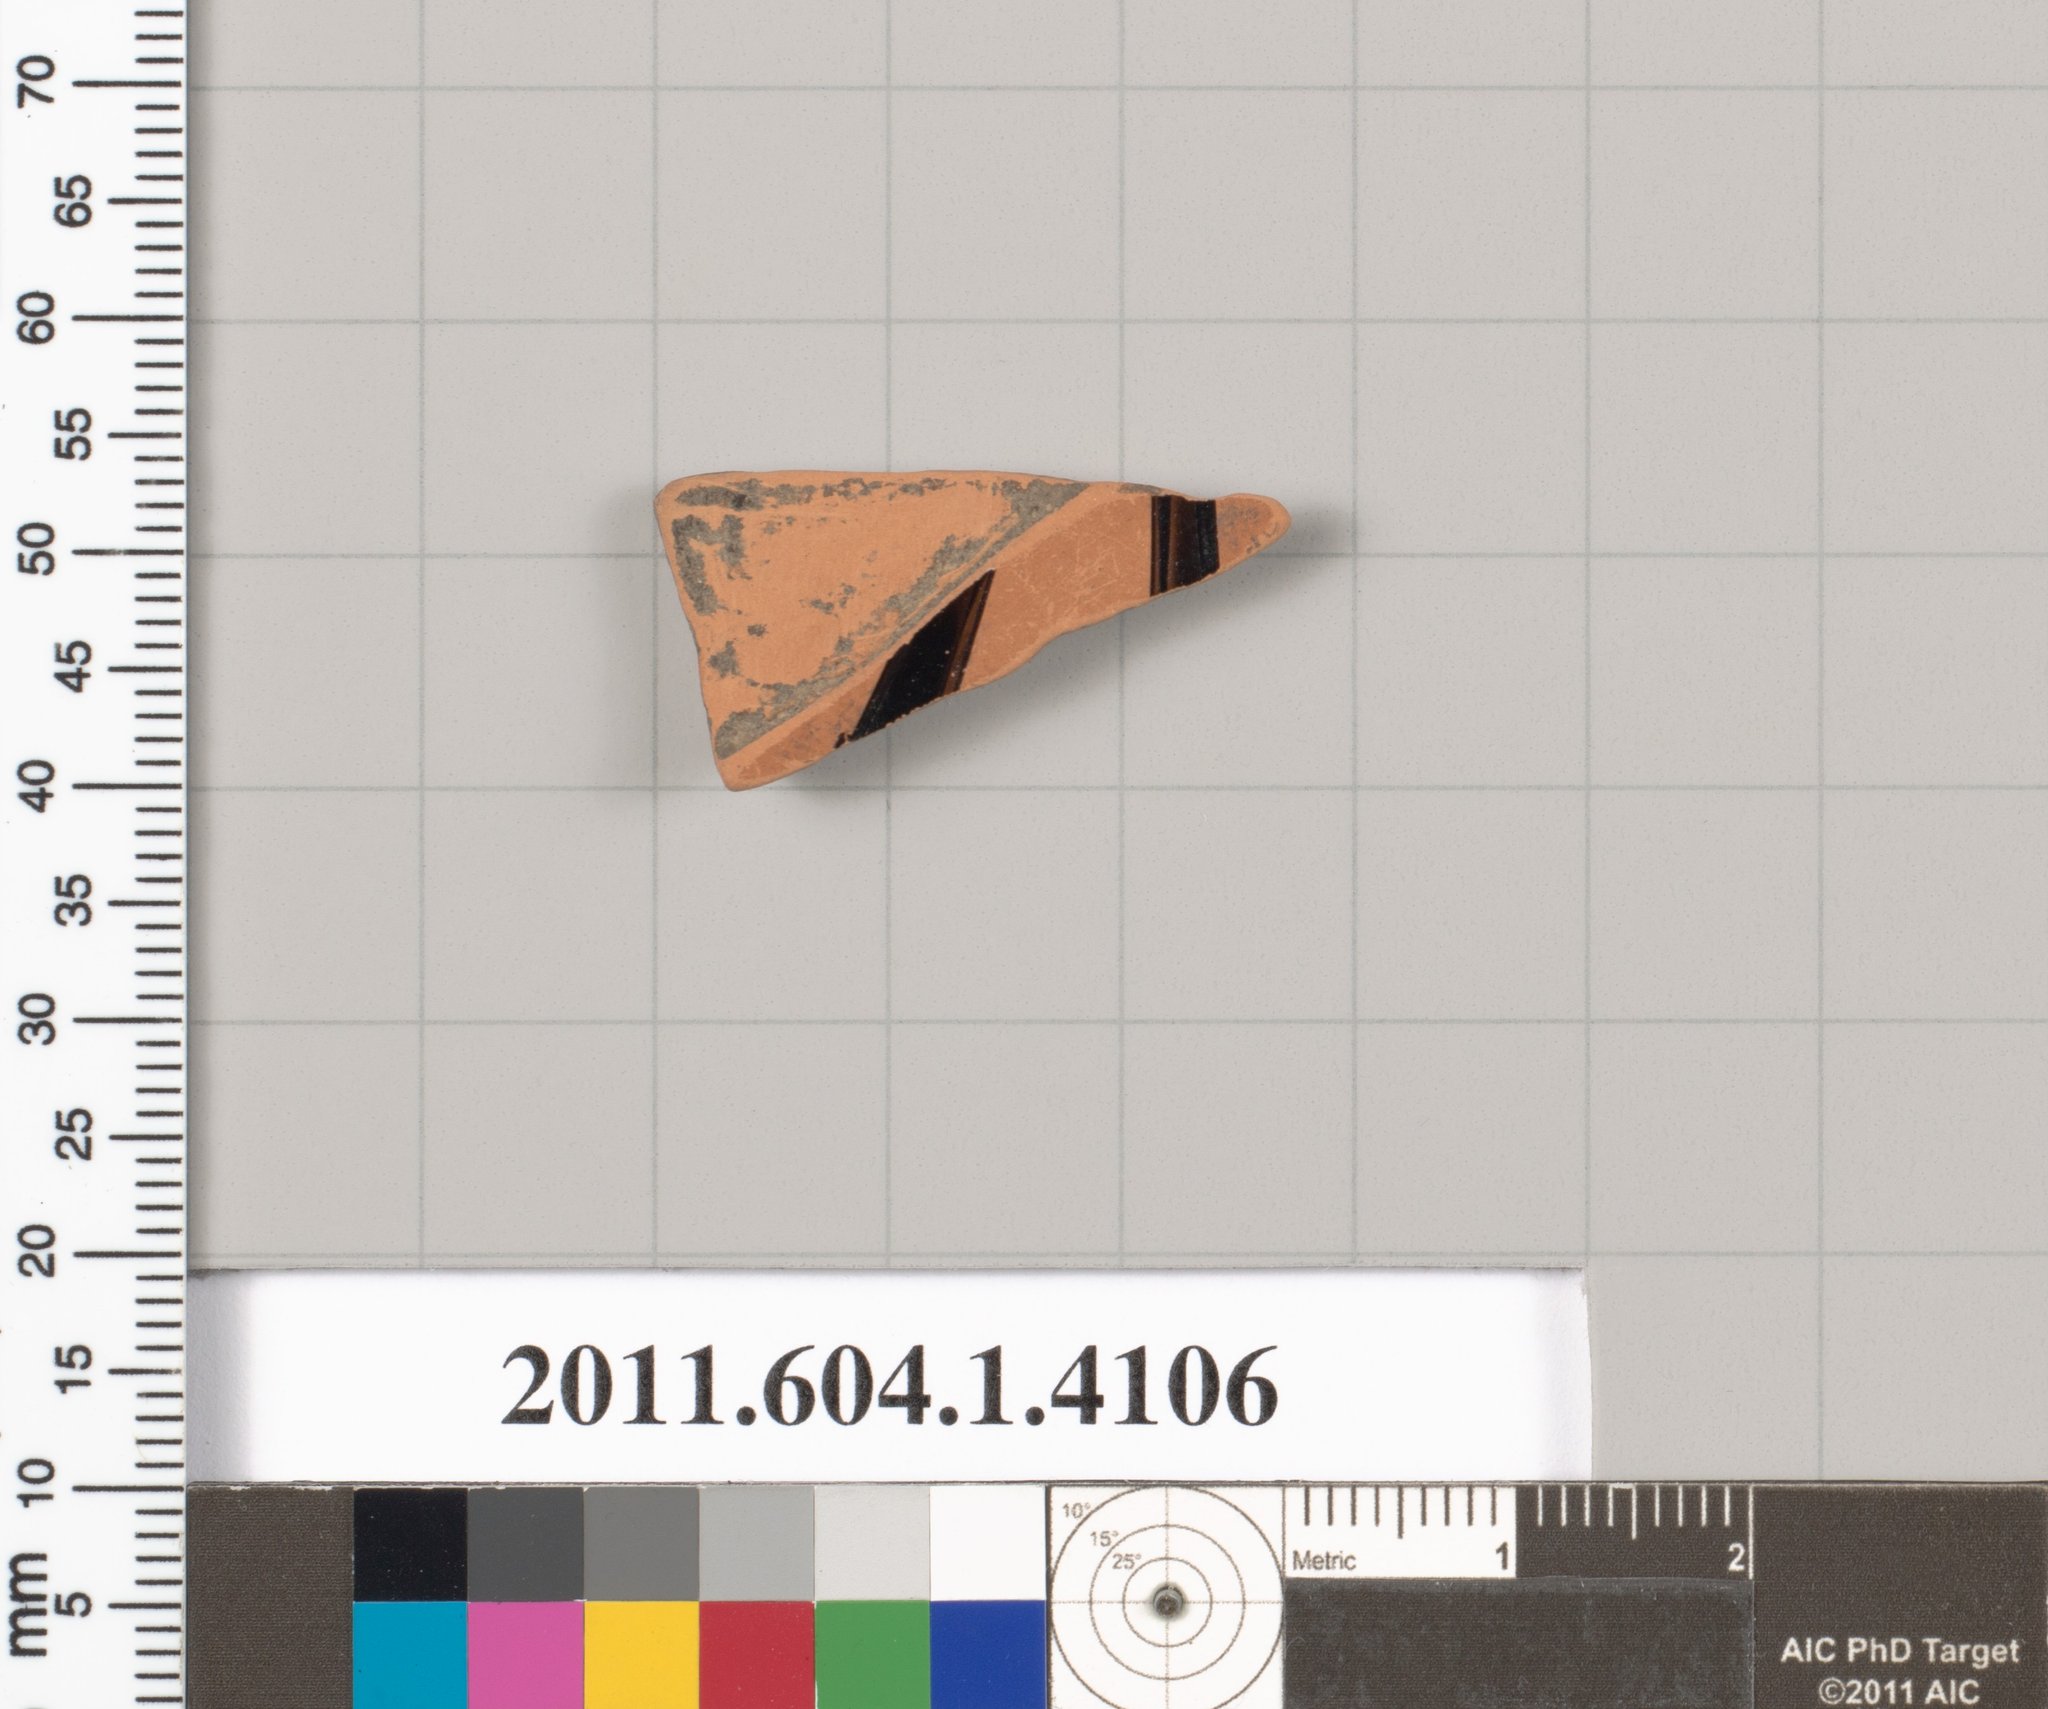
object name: kylix fragment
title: Terracotta fragment of a kylix (drinking cup)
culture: greek, attic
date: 520-490 BCE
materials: terracotta